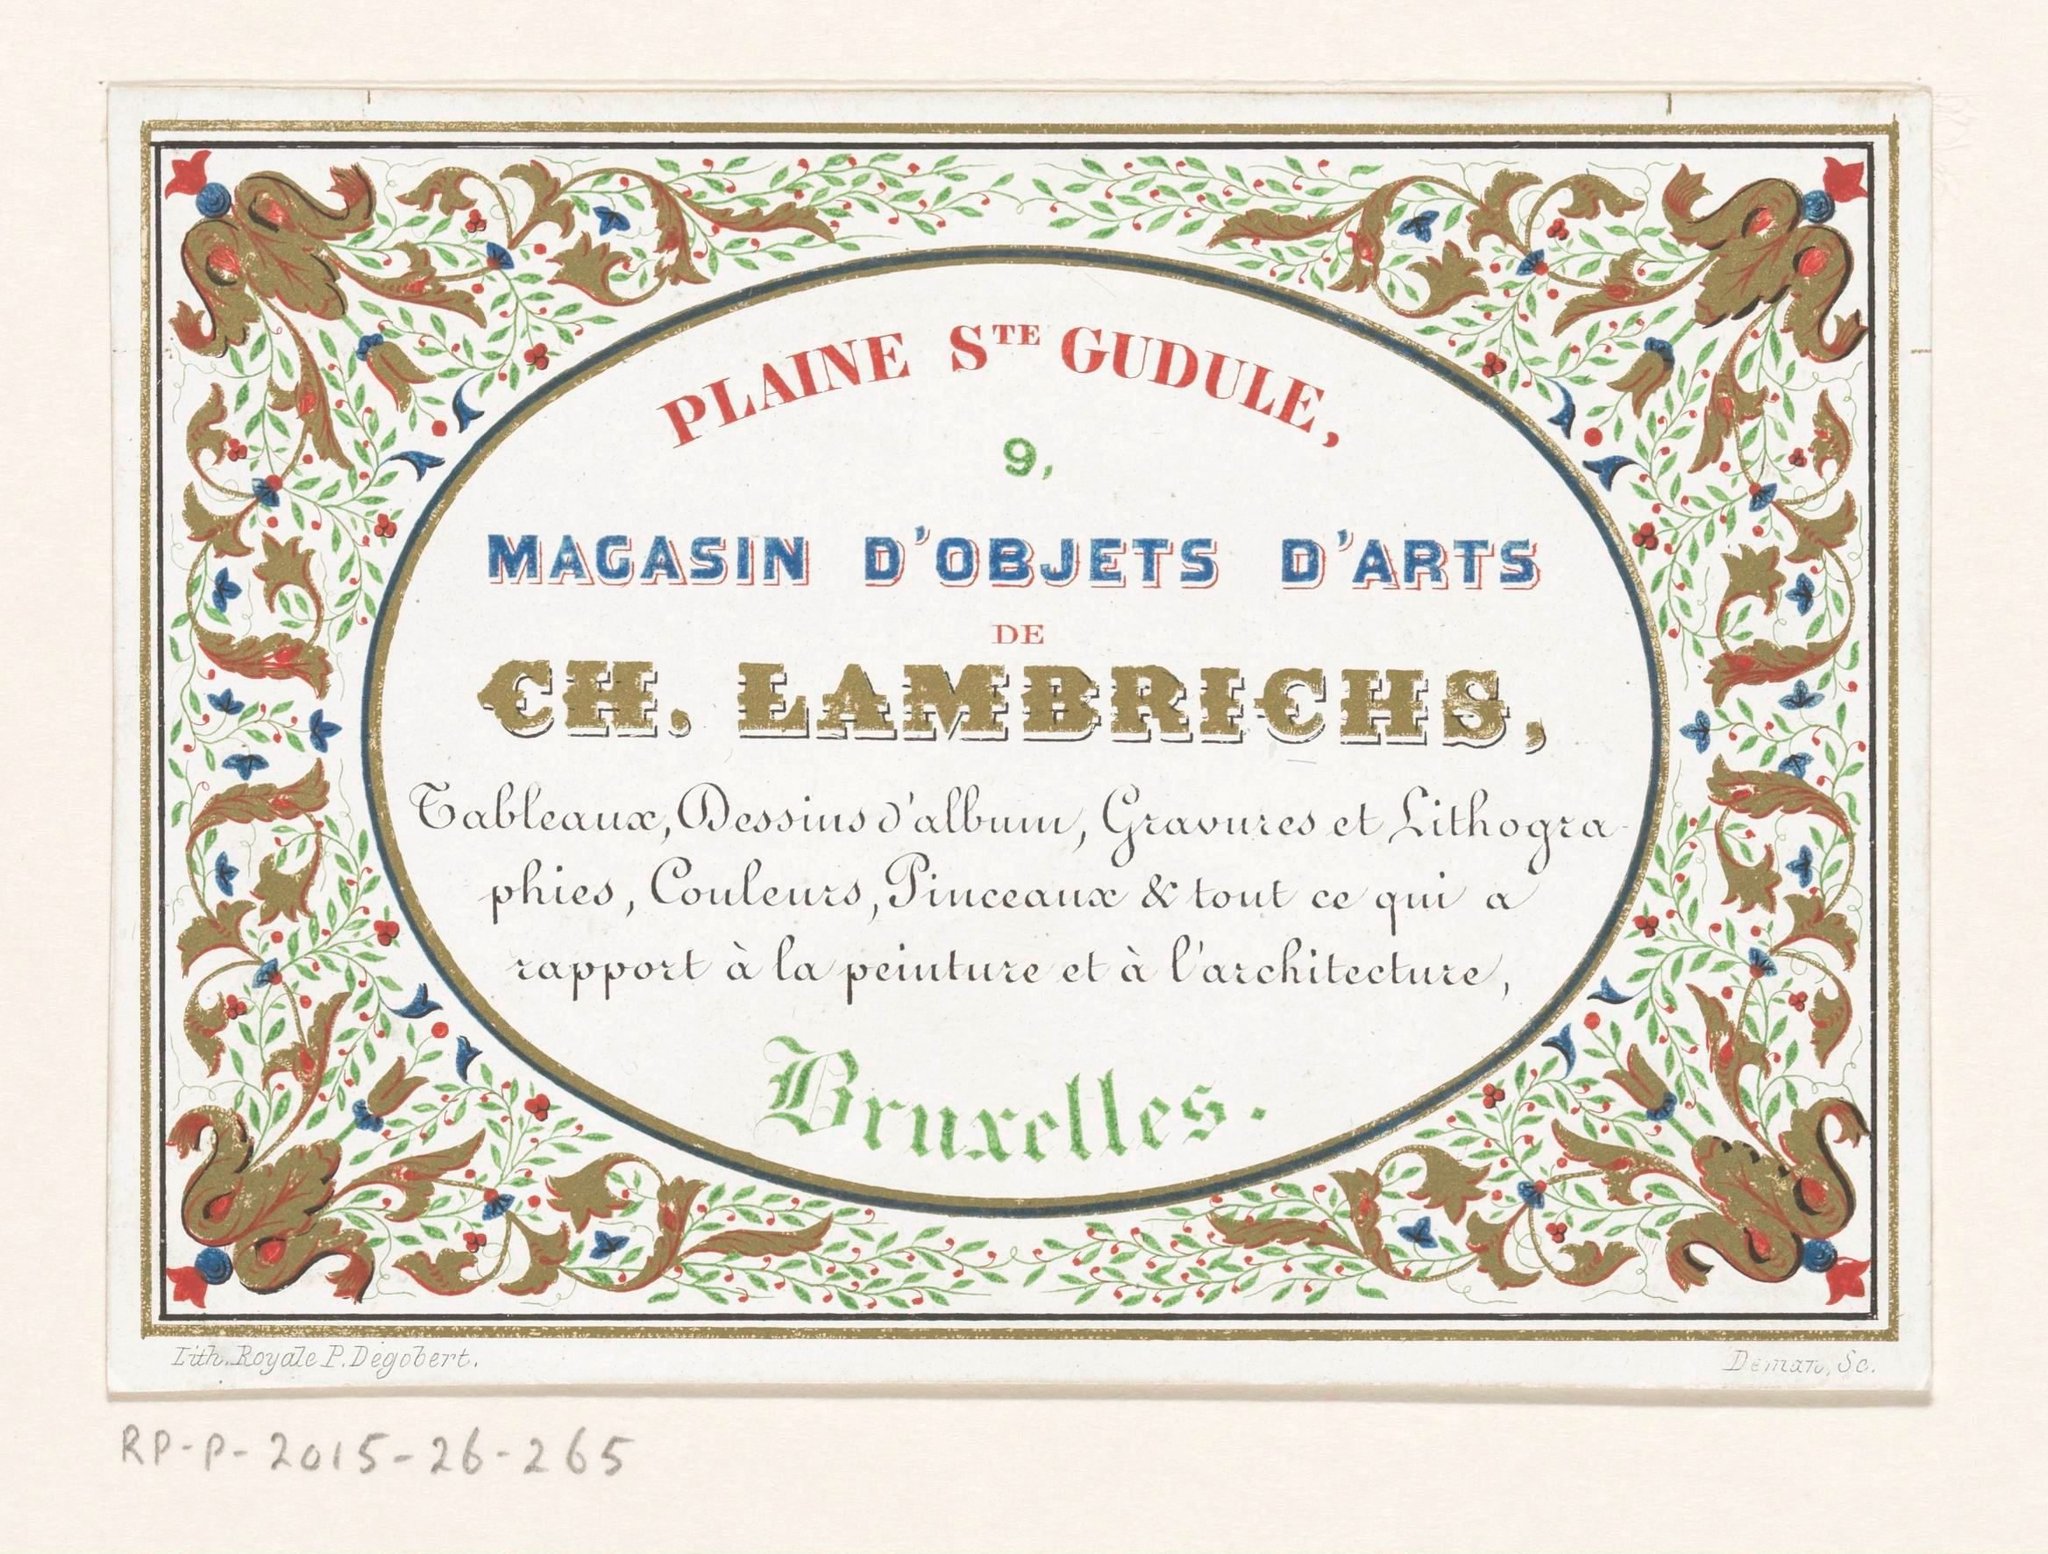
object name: visiting card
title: Visitekaartje van kunsthandel Ch. Lambrichs te Brussel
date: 1841-1844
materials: porcelainized cardboard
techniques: lithograph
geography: brussels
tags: art dealer, ornament derived from plant forms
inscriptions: stamp: ‘timbre d'avis Brabant 1 C’, collector's mark: Lugt 2228